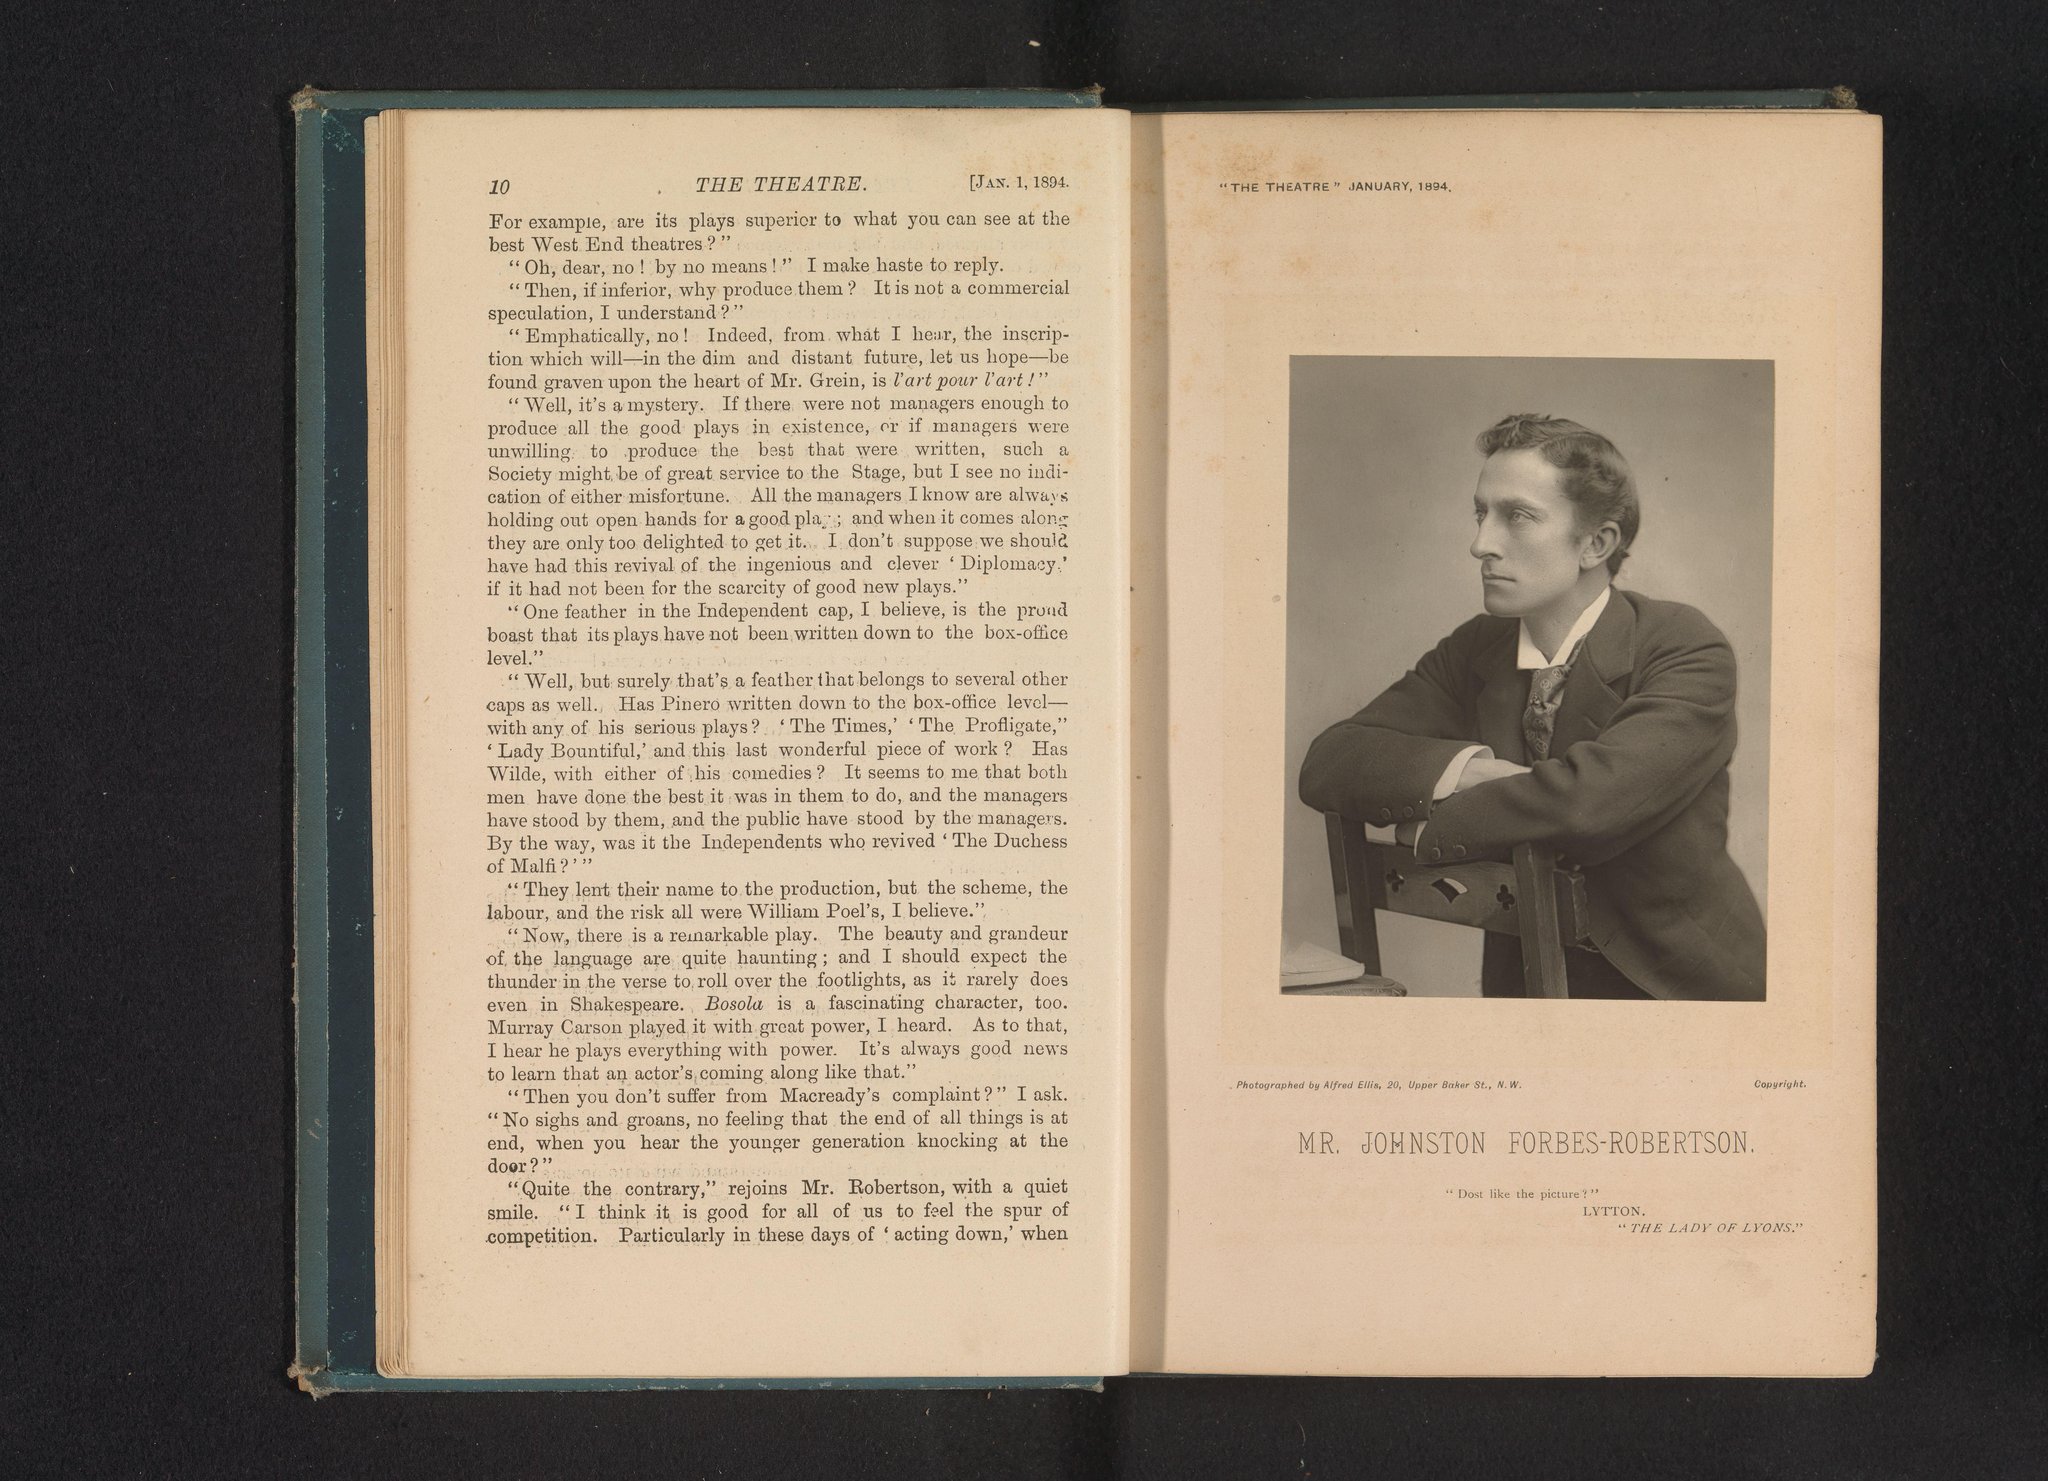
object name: page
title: Mr. Johnston Forbes-Robertson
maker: alfred ellis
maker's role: fotograaf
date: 1889-1894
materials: paper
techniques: carbon print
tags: adult man, historical persons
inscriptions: inscription: ‘'The Theatre' January, 1894.’, inscription: ‘'Dost like the picture?'/ Lytton/ 'The Lady of Lyons'’